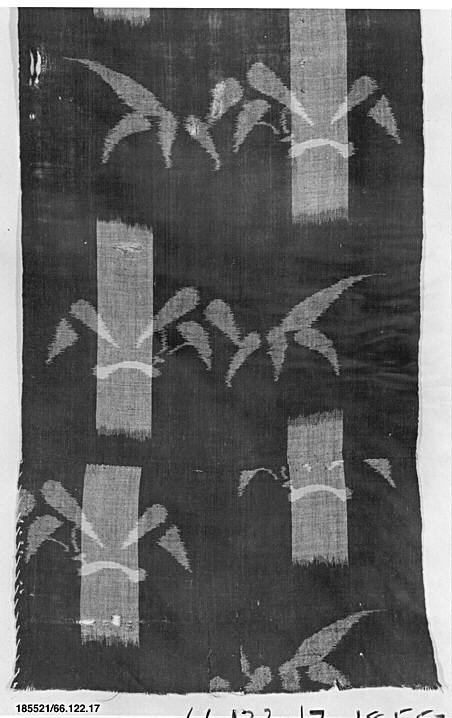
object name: bedding piece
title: Piece of Cloth for Bedding with Pattern of Bamboo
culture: japanese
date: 1801-1900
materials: cotton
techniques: patterning, weave